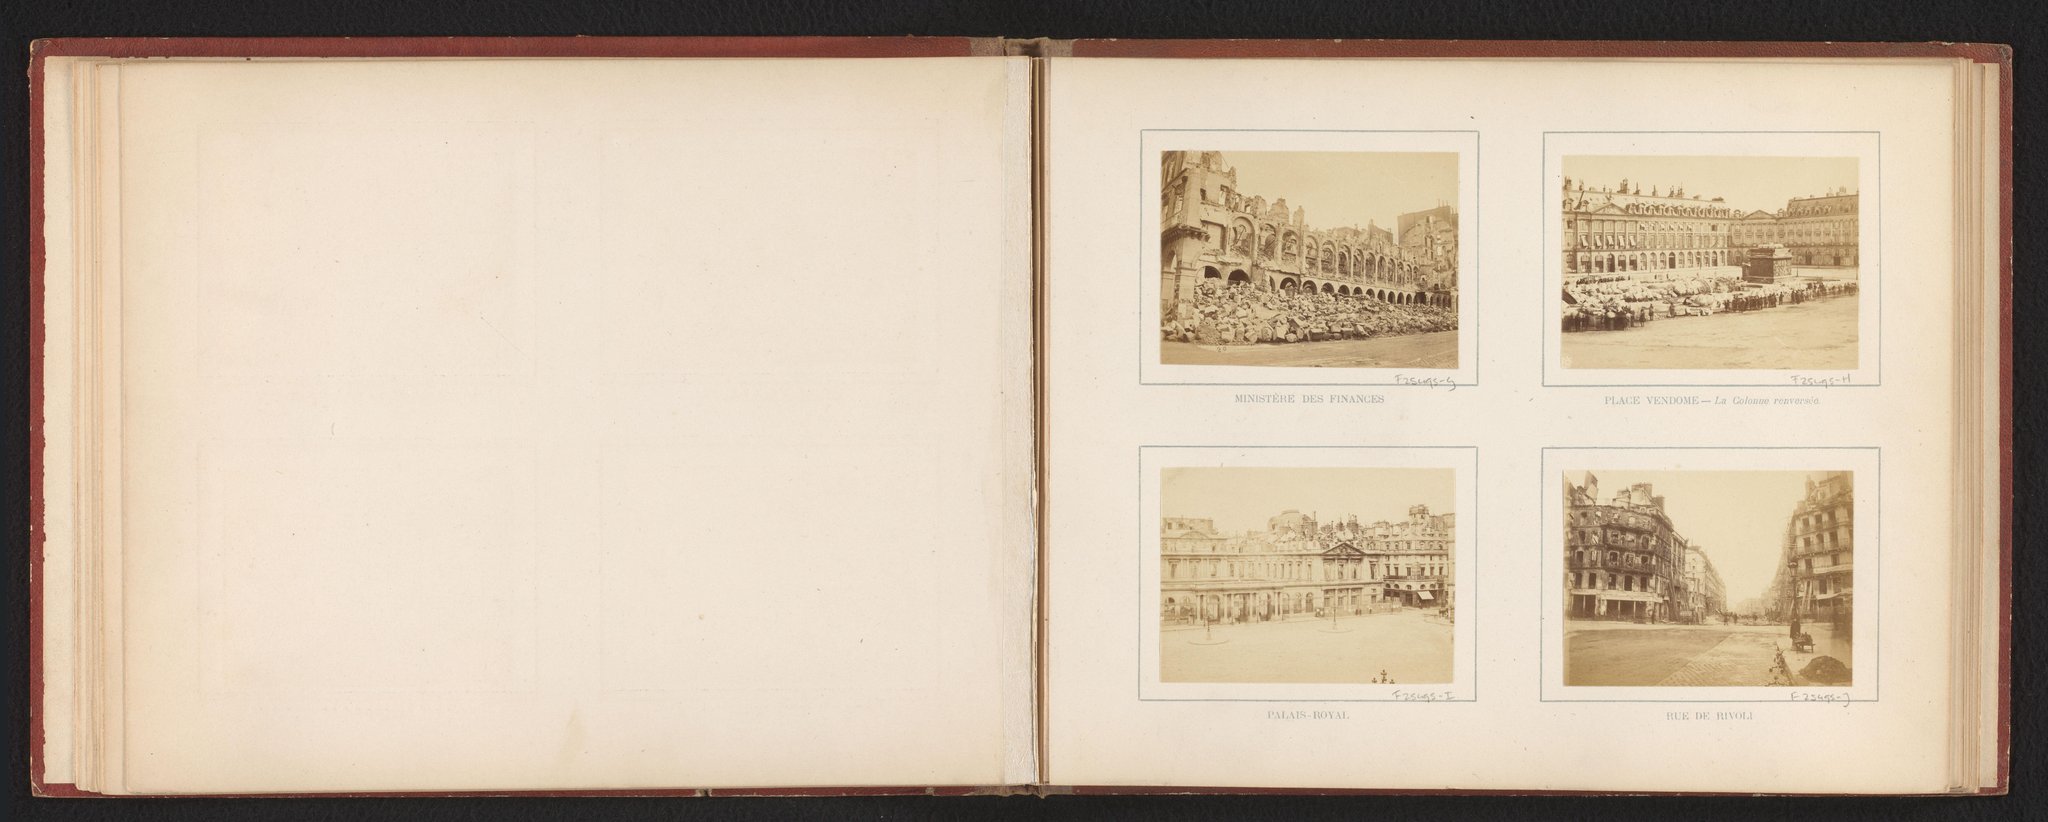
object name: photograph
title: Gezicht op het verwoeste ministerie van financiën bij het Louvre in Parijs na de semaine sanglante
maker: Anonymous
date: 1871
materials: paper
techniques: albumen print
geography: paris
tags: ruin of a building ~ architecture